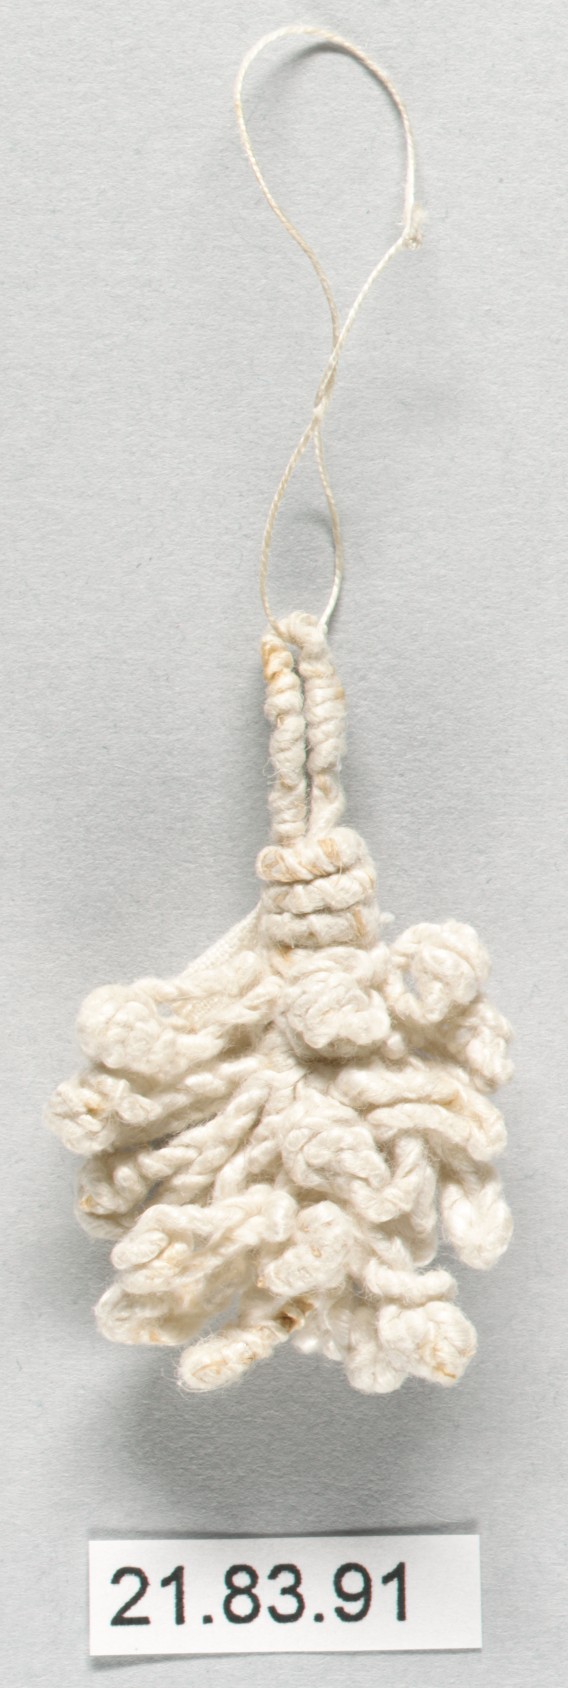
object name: tassel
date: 1601-1700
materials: linen